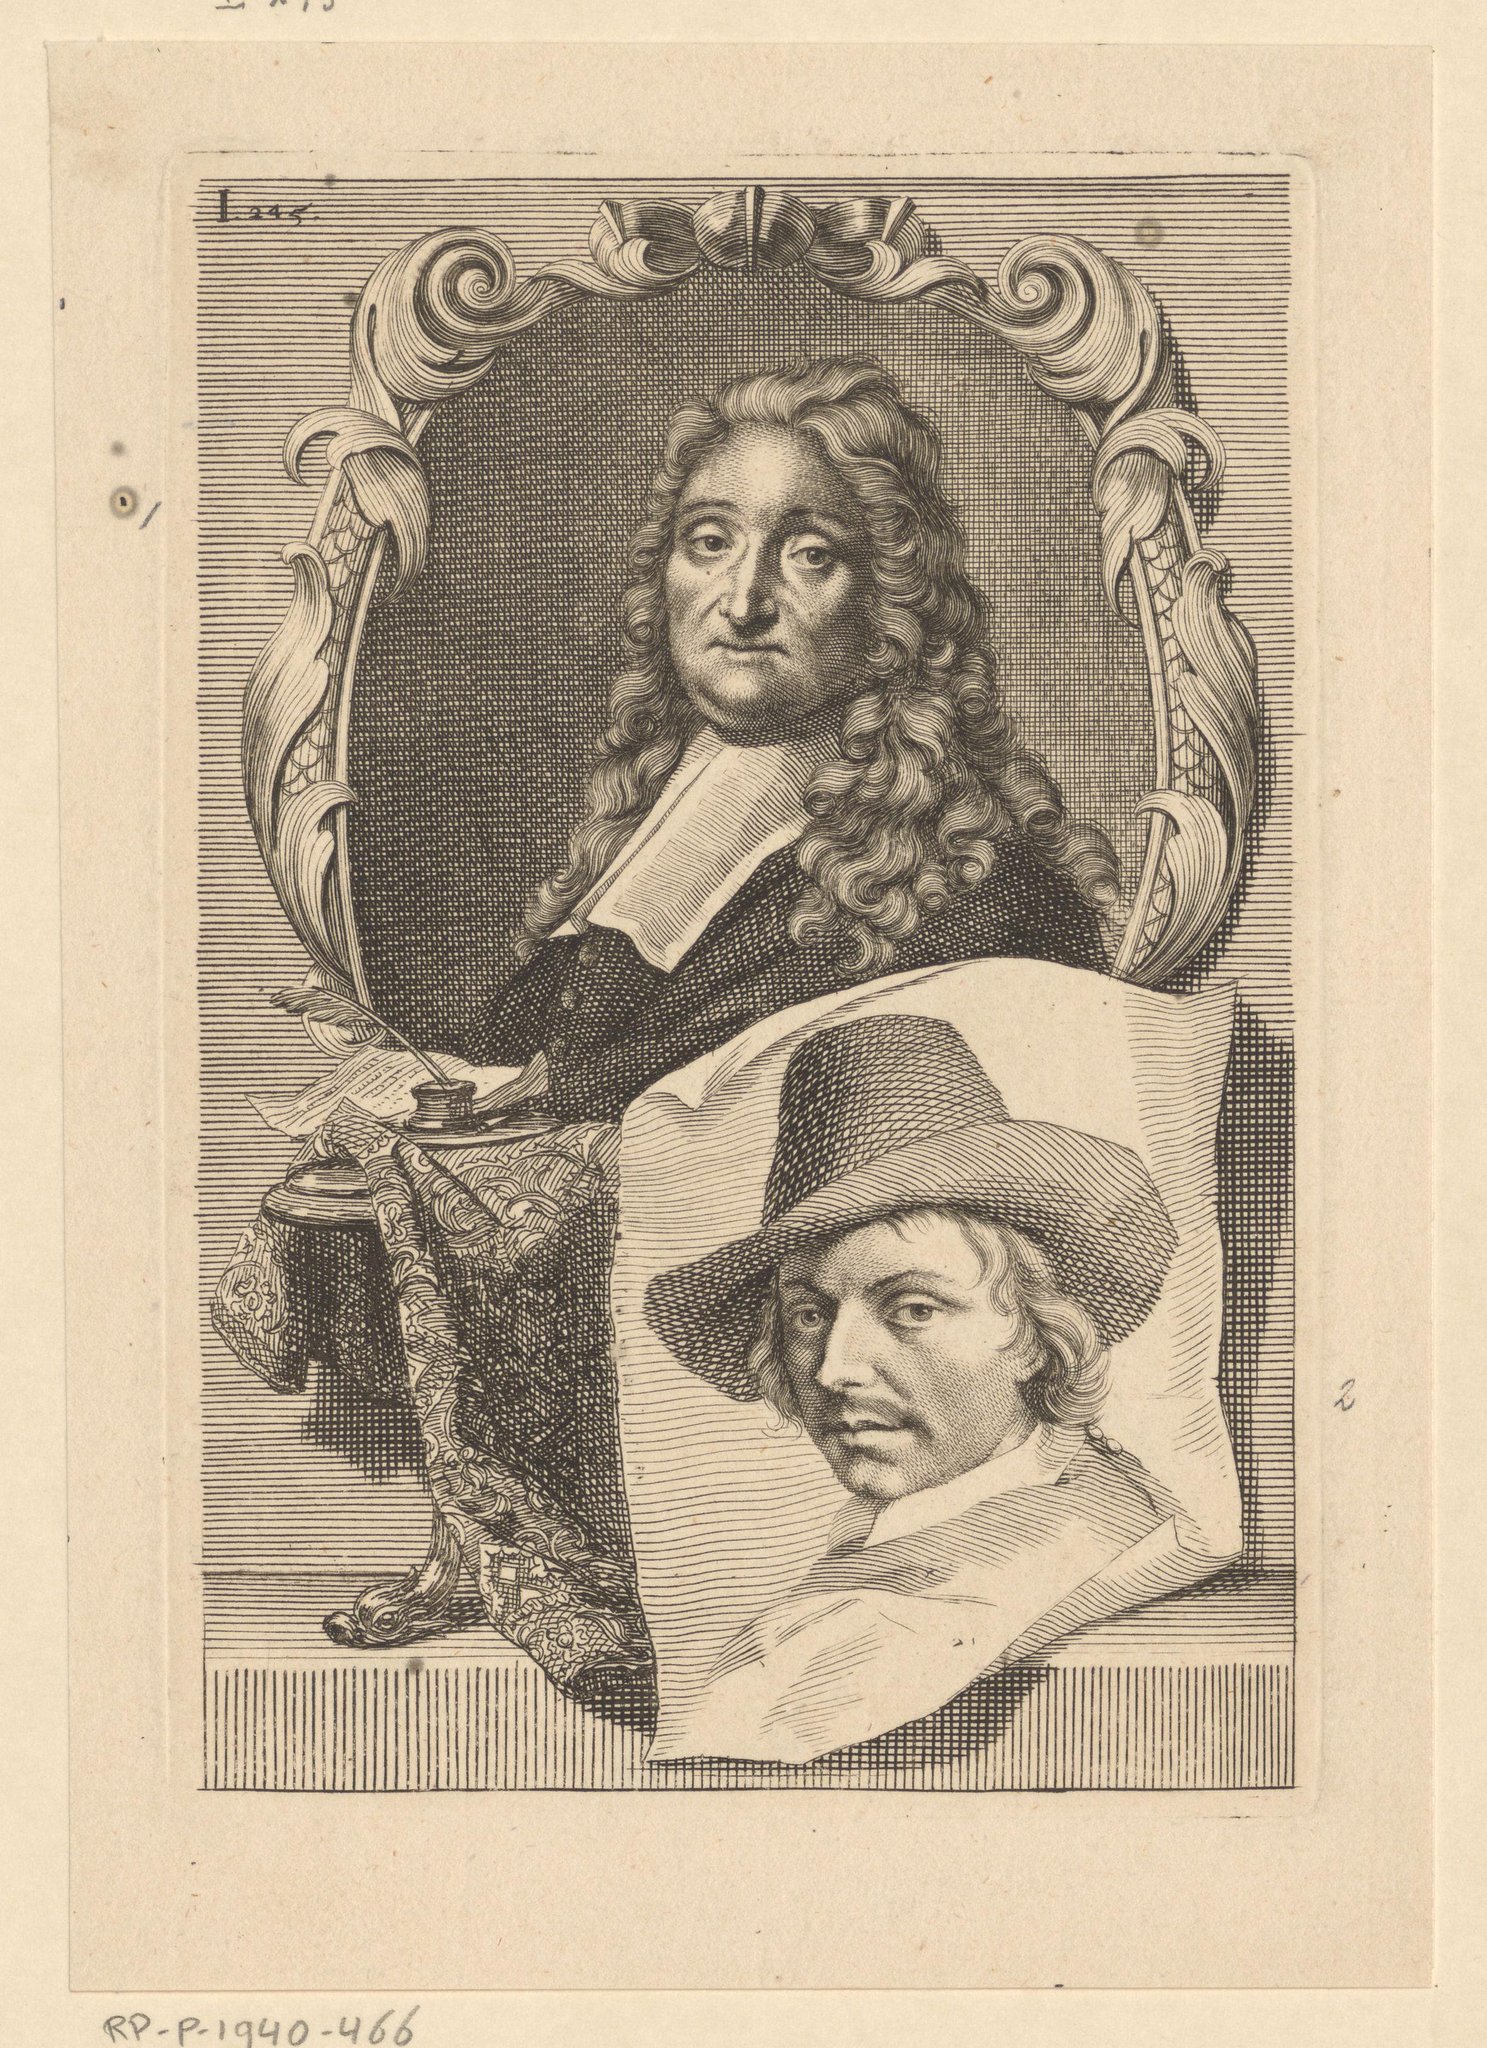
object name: book illustration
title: Portretten van Ludolf Bakhuysen en Vincent Laurensz. van der Vinne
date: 1718-1799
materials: paper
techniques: engraving, etching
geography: the hague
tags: ludolf bakhuysen, vincent laurensz. van der vinne (i), historical persons, portrait, self-portrait of artist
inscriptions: collector's mark: Lugt 2760, collector's mark: Lugt 2228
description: Prent voor het eerst verschenen in: Houbraken, Arnold. De groote schouburgh der Nederlantsche konstschilders en schilderessen (...). Amsterdam: Arnold Houbraken, 1718-1721. Later ook verschenen in: Weyerman, Jacob Campo. De levens-beschryvingen der Nederlandsche konst-schilders en konst-schilderessen (...). Den Haag: weduwe Engelbrecht Boucquet, Frederik Bouquet, Hendrik Scheurleer en Jacobus de Jongh, 1729.